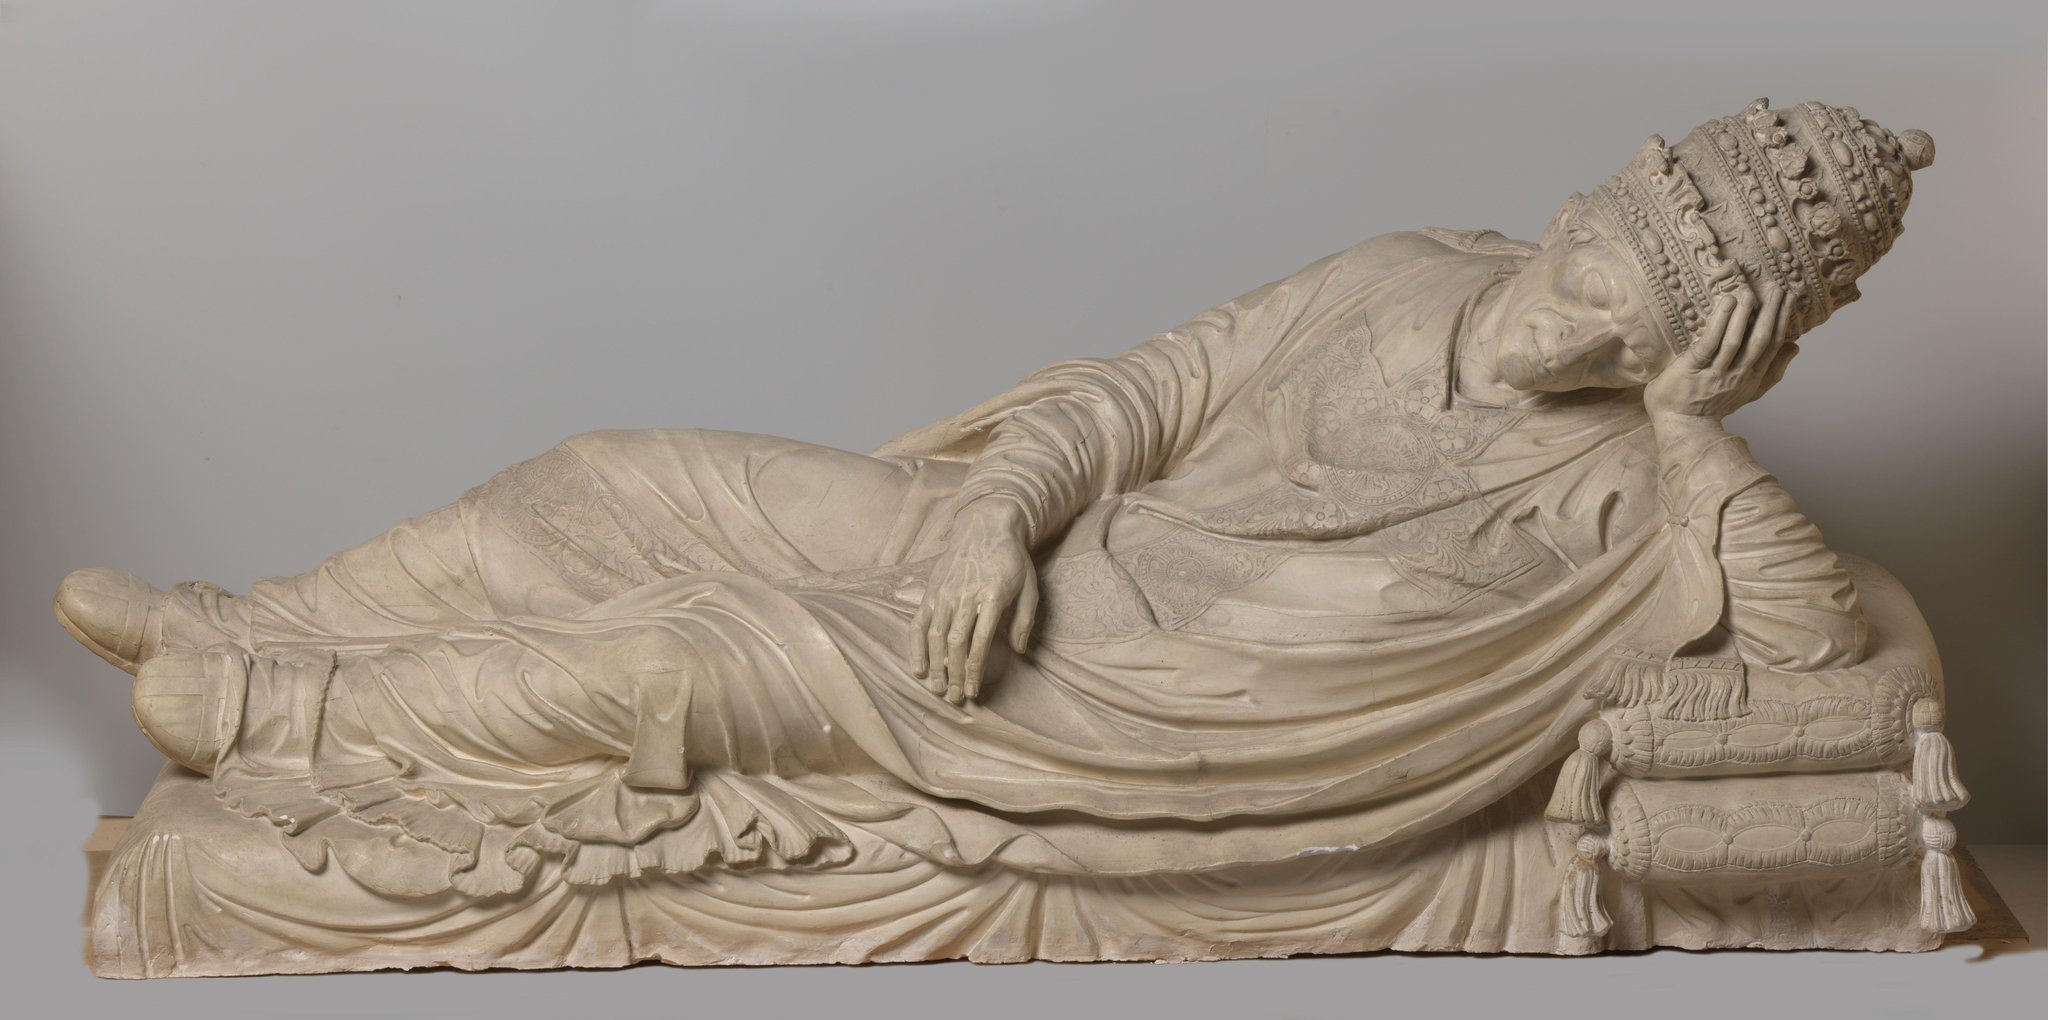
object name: cast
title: Deksel van sarcofaag; onderdeel grafmonument van Paus Adrianus VI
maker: alberto galli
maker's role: sculptor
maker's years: 1840-1920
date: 1523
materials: gypsum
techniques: casting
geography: italy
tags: utrecht, rome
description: Deksel van sarcofaag; onderdeel grafmonument van Paus Adrianus VI.